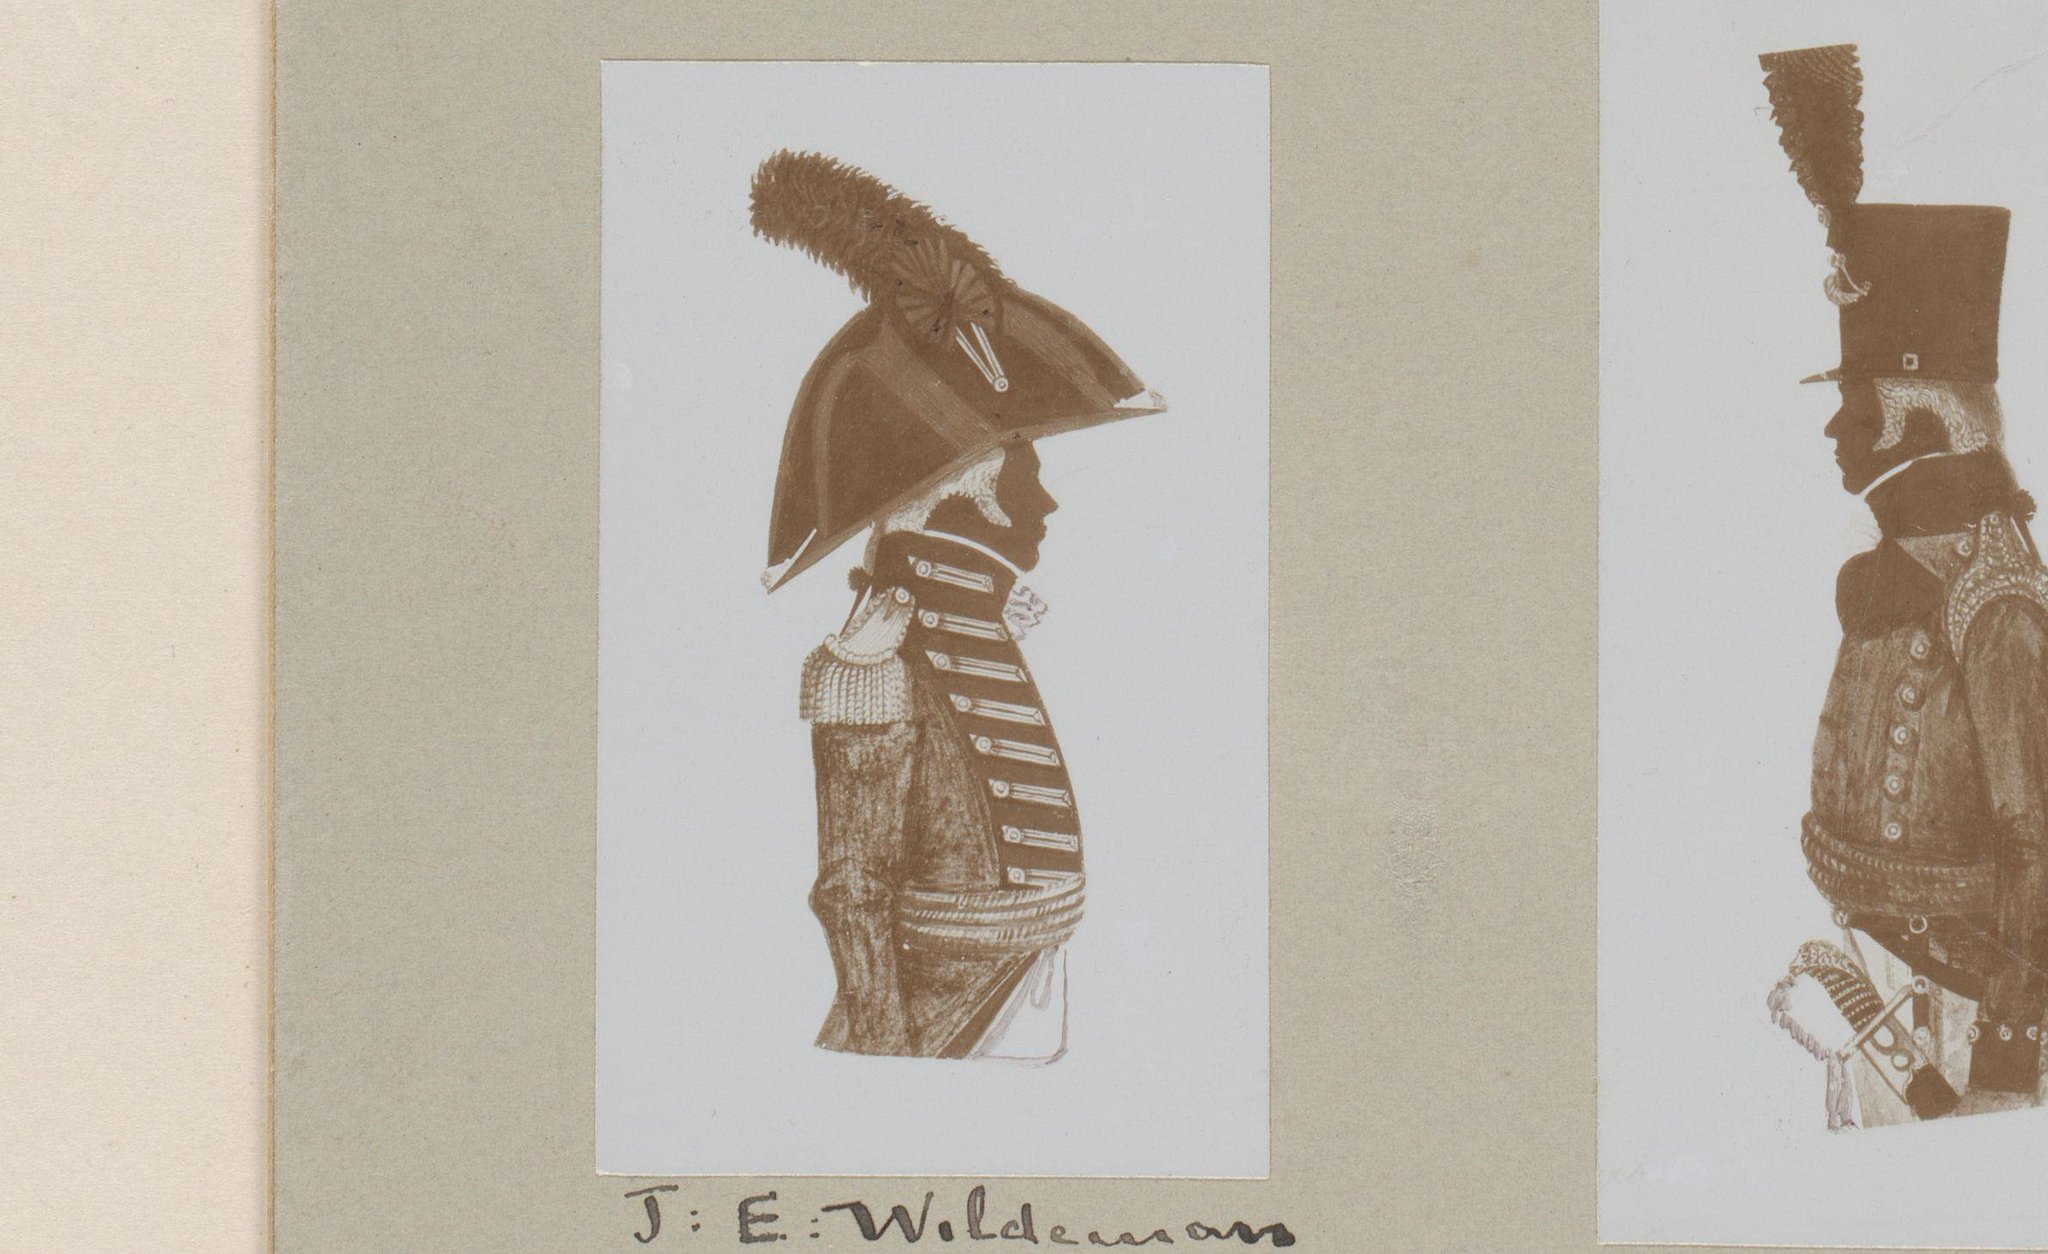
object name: reproduction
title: Fotoreproductie van een silhouetteportret van Jan Ernst Wildeman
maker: Anonymous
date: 1880-1905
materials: paper, cardboard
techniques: collodion silver print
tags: harlingen, historical persons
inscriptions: inscription: ‘J:E: Wildeman/ 1770-1833/ als Kapt: der Genie/ Holl: Brigade/ op Wight’, collector's mark: Lugt 2228